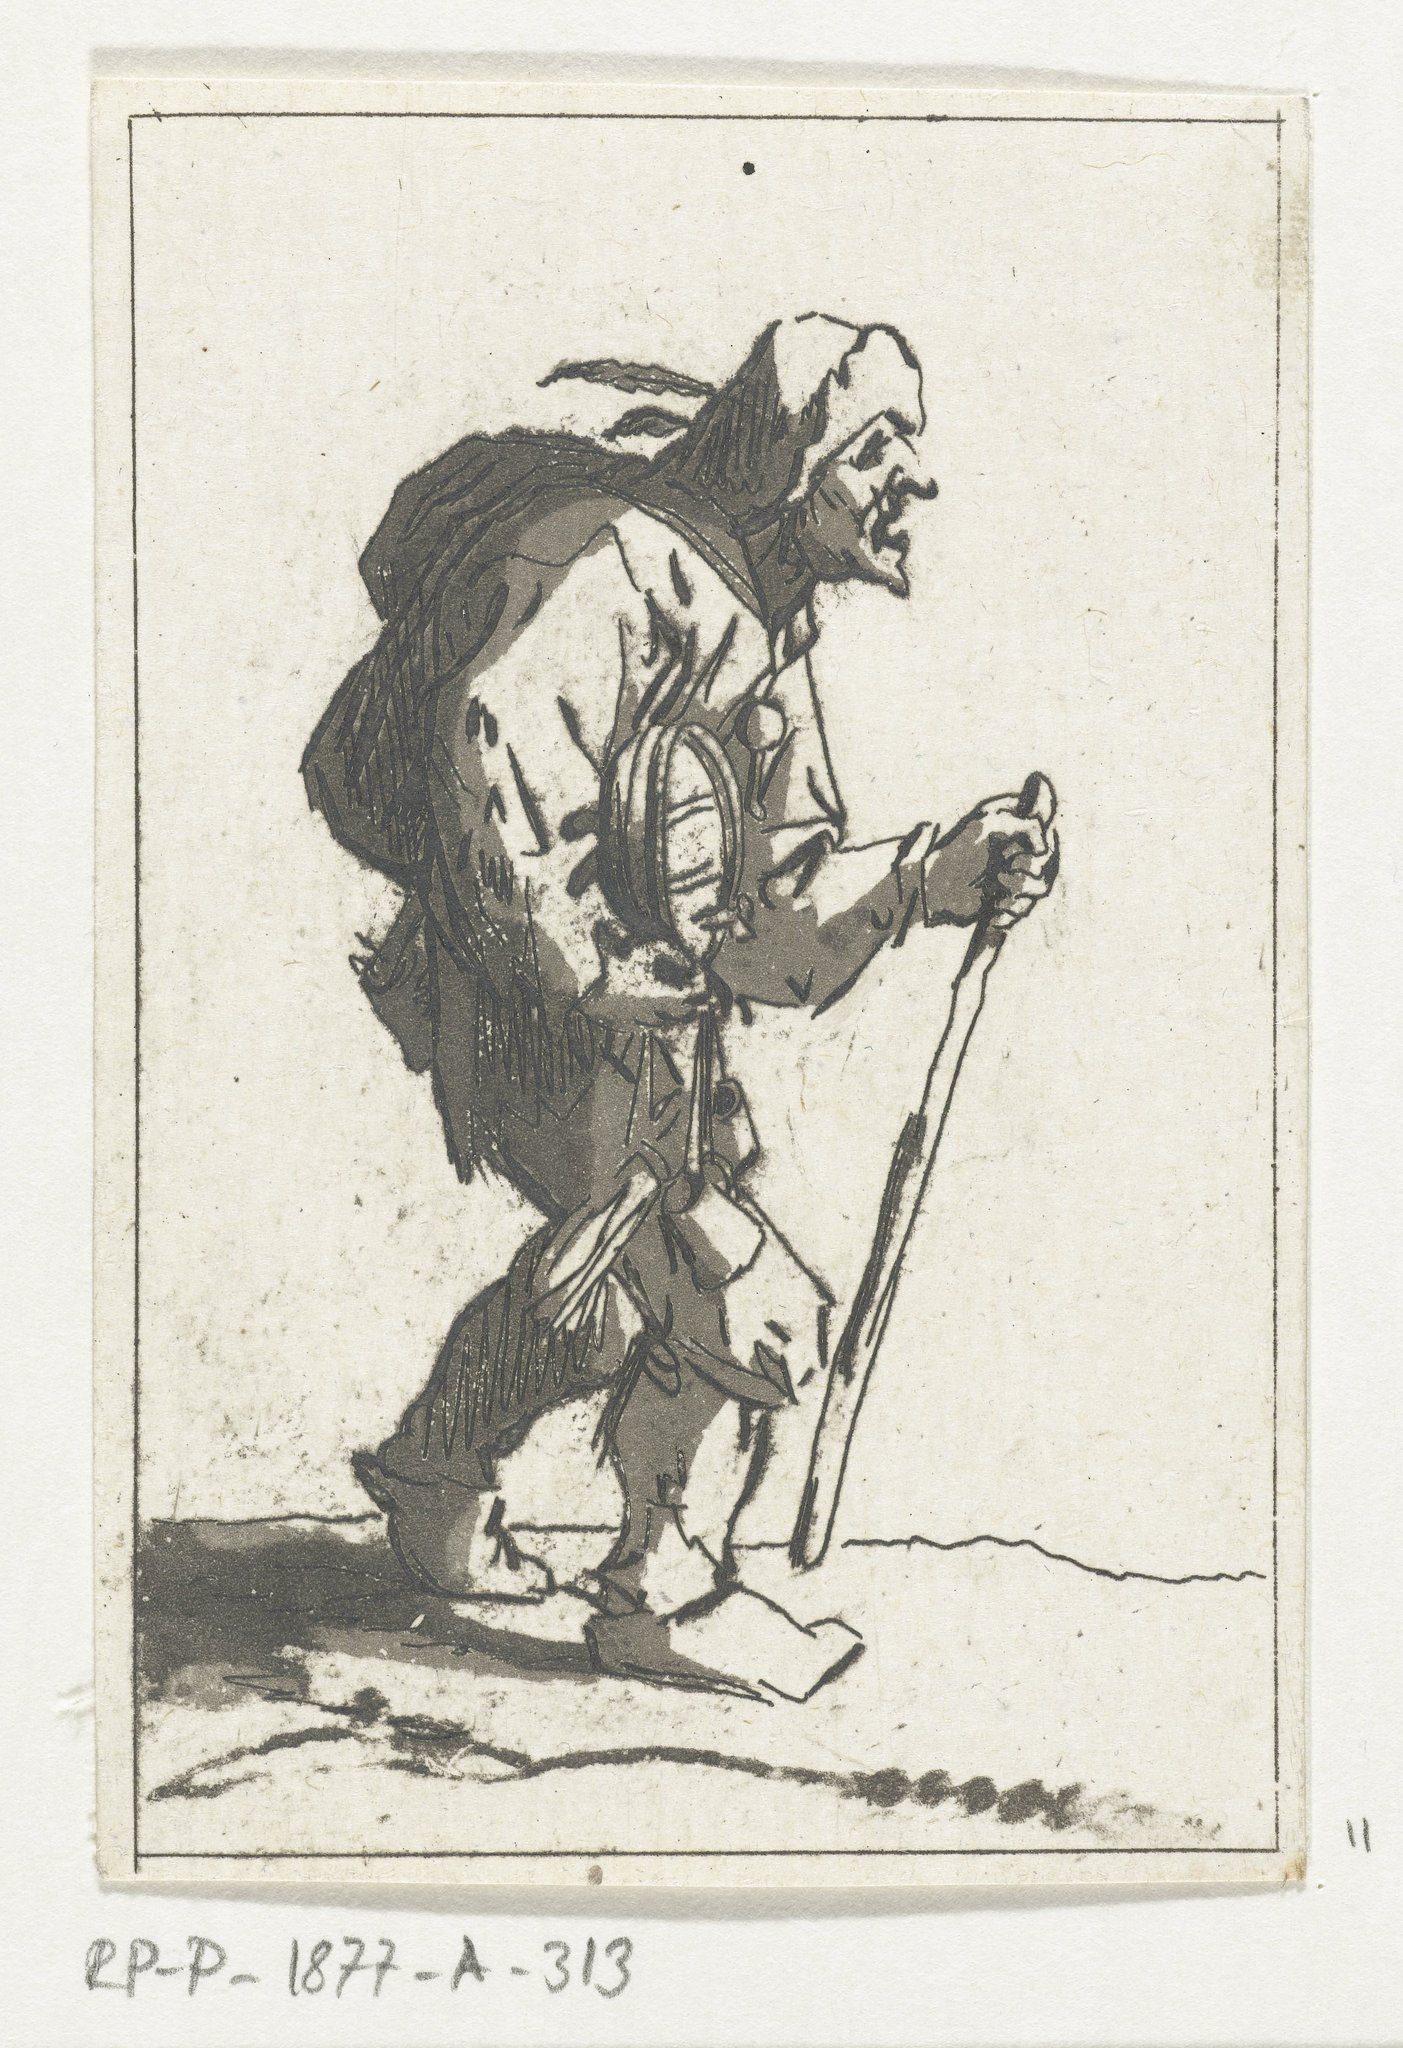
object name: print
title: Inkt- en pennenkoopman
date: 1778-1838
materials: paper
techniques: aquatint, etching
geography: netherlands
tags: ink-well, street-trader, pencil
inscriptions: collector's mark: Lugt 2228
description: Een koopman lopend met een stok in zijn hand. Hij heeft een vaatje onder zijn rechterarm, en houdt met zijn rechterhand inktkokers en pennen vast, die aan een koord hangen.